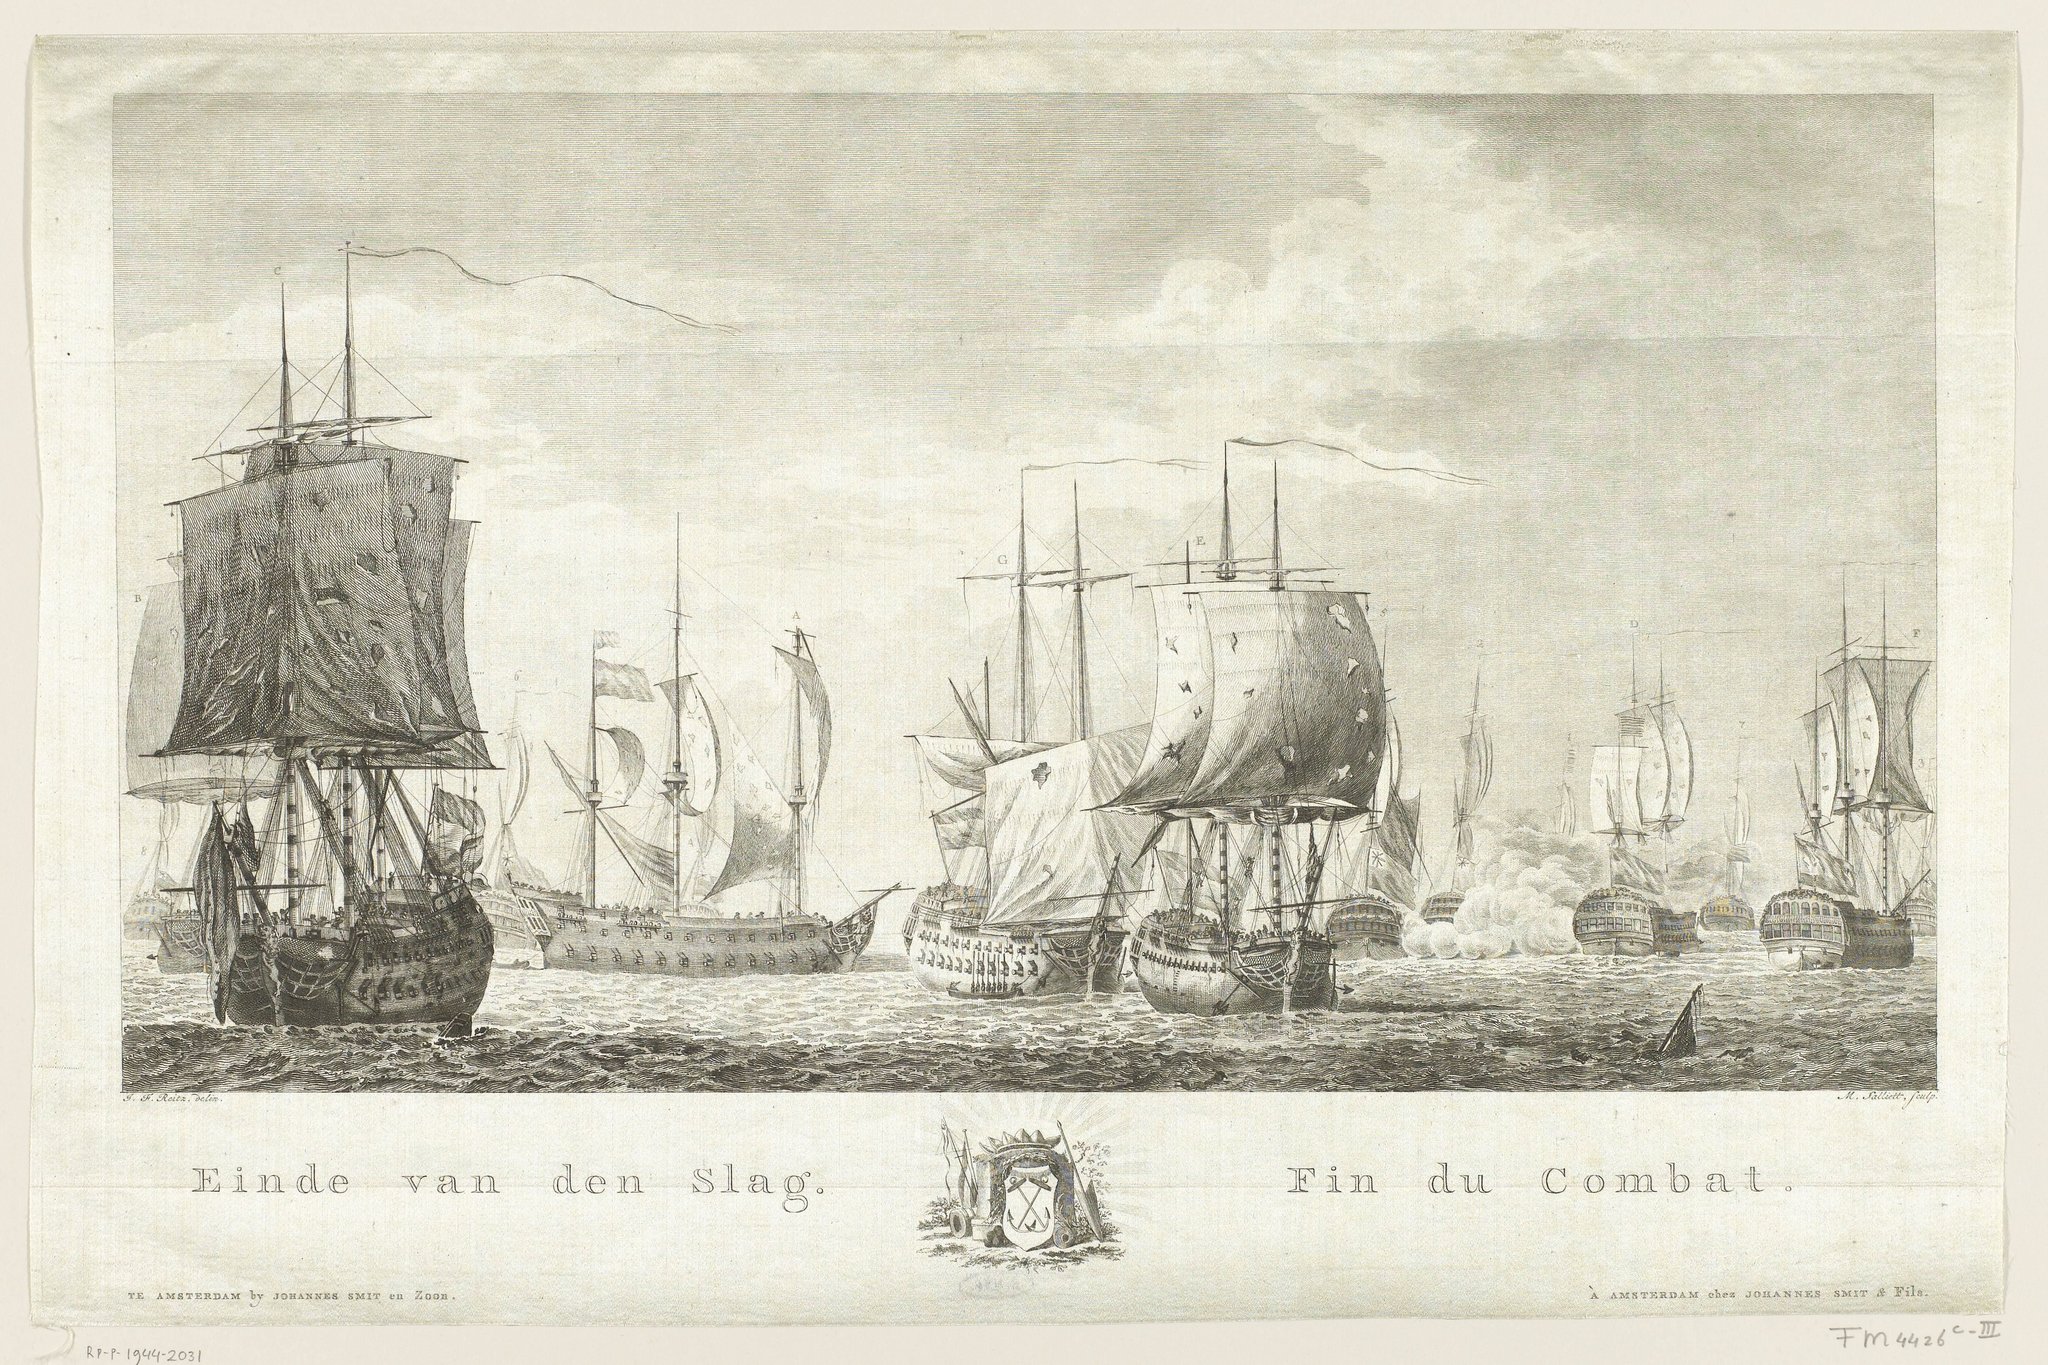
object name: print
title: Einde van de zeeslag bij Doggersbank, 1781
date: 1782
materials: textile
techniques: engraving, etching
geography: amsterdam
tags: the hague, johan arnold zoutman, hyde parker, battle (+ naval force)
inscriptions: collector's mark: Lugt 2228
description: Het einde van de zeeslag bij Doggersbank op 5 augustus 1781 tussen de Nederlandse vloot onder schout-bij-nacht Johan Zoutman en de Engelse vloot onder vice-admiraal Hyde Parker. In de marge de titels in het Nederlands en Frans. Onderdeel van een serie van drie platen van de Zeeslag op de Doggersbank, op satijn.